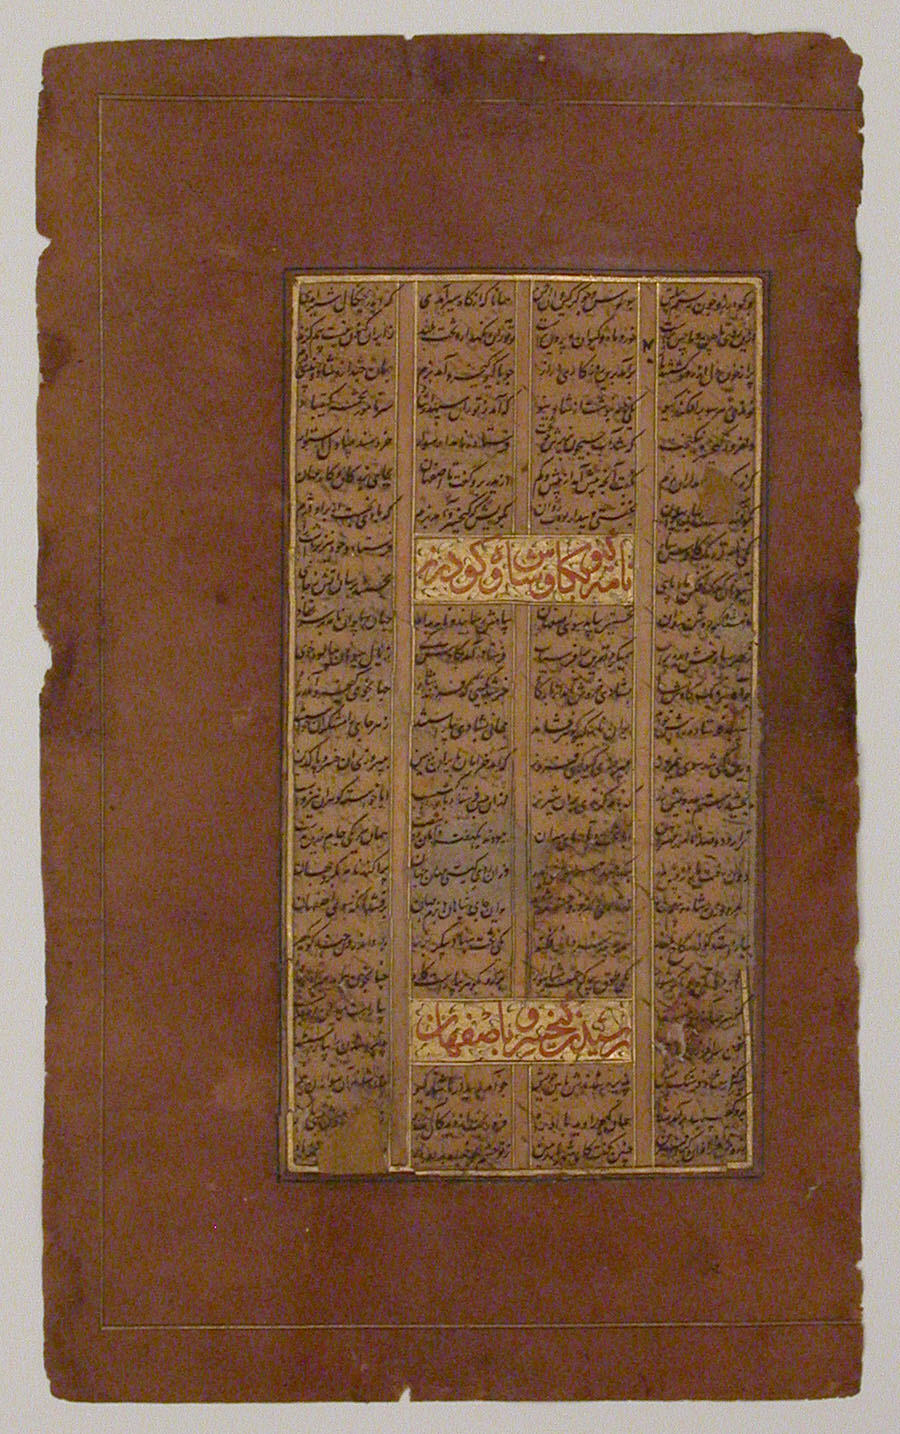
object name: folio from an illustrated manuscript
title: Page of Calligraphy from a Shahnama (Book of Kings) of Firdausi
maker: abu'l qasim firdausi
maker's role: author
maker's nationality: iranian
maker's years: 935-1020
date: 1610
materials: gold, ink, paper, watercolor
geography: india